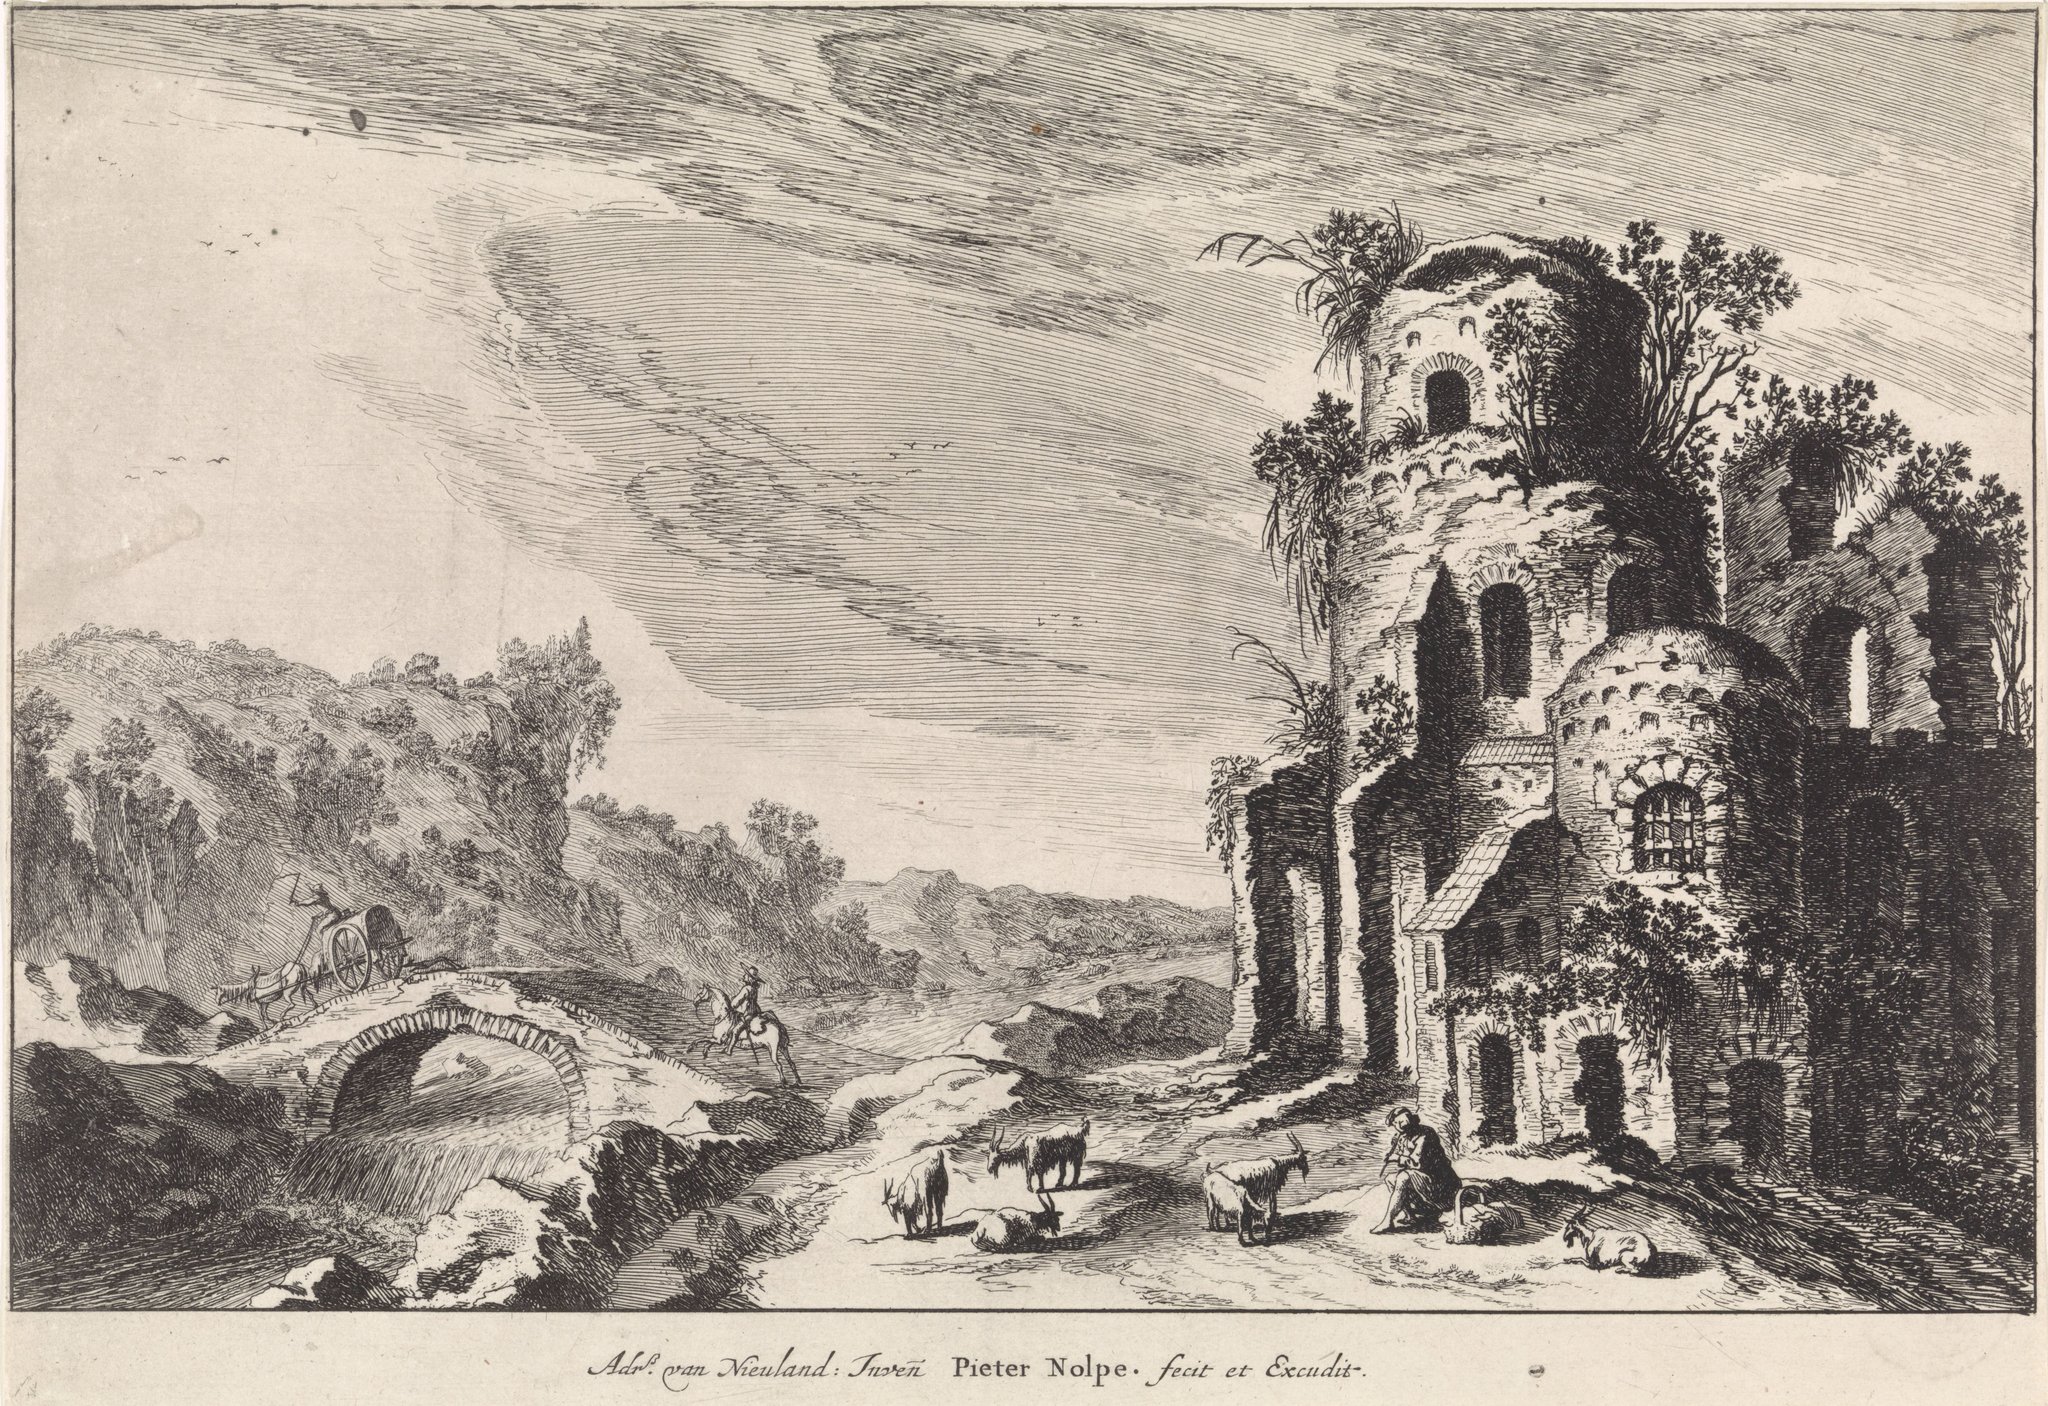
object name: print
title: Landschap met een brug en een ruïne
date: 1623-1653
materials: paper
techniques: engraving, etching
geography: amsterdam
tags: landscape with ruins, bridge, goat, flute, aulos, tibia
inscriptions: collector's mark: Lugt 240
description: Links een begroeide ruïne en een geitenhoeder, die op een fluit speelt. Rechts rijden een ruiter en een koets over een brug. Prent uit een serie landschappen.